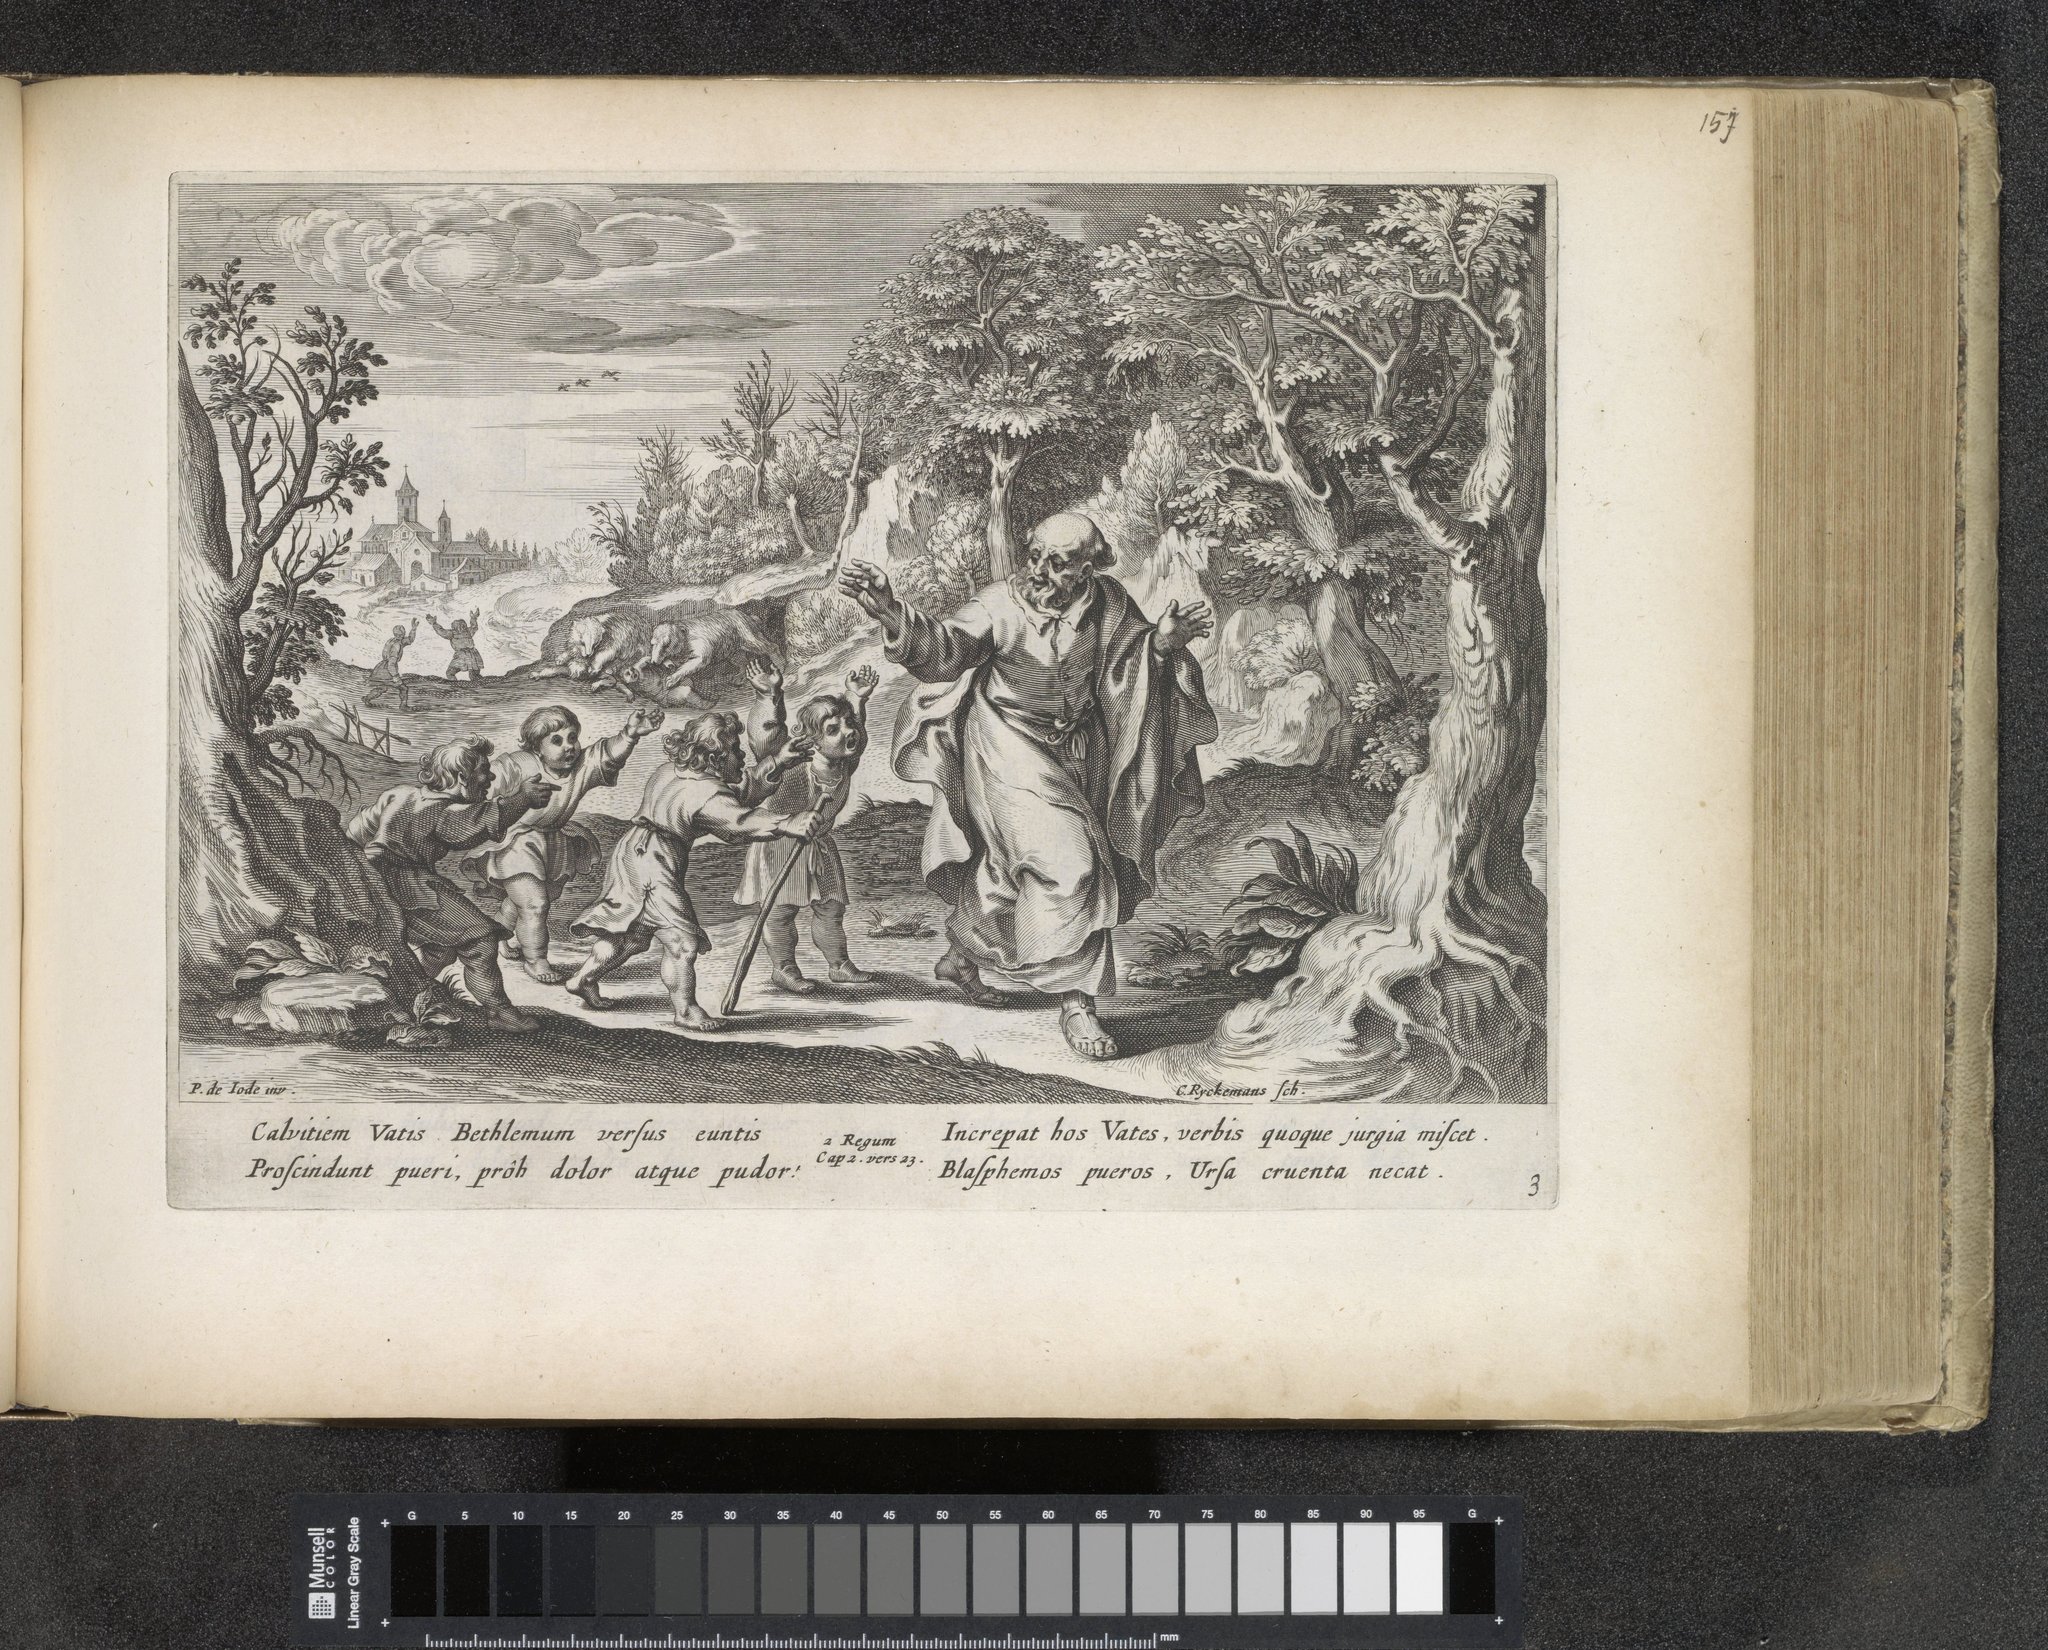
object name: album leaf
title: Theatrum Biblicum Hoc Est Historiae Sacrae Veteris et Novi Testamenti Tabulis Aeneis Expressae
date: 1616-1636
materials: paper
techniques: engraving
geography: amsterdam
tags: the cursing of the children: when elisha is on his way some children mock him for his baldness; elisha curses them (2 kings 2:23-25), two bears come out of the woods and tear the children who were mocking elisha to pieces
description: Elisa wordt op weg naar Betel uitgescholden door kinderen vanwege zijn kale hoofd en hij vervloekt hen. Twee beren verslinden vervolgens de kinderen op de achtergrond. Onder de voorstelling een verwijzing in het Latijn naar de Bijbeltekst in 2 Kon. 2:23. Deze prent maakt deel uit van een album.